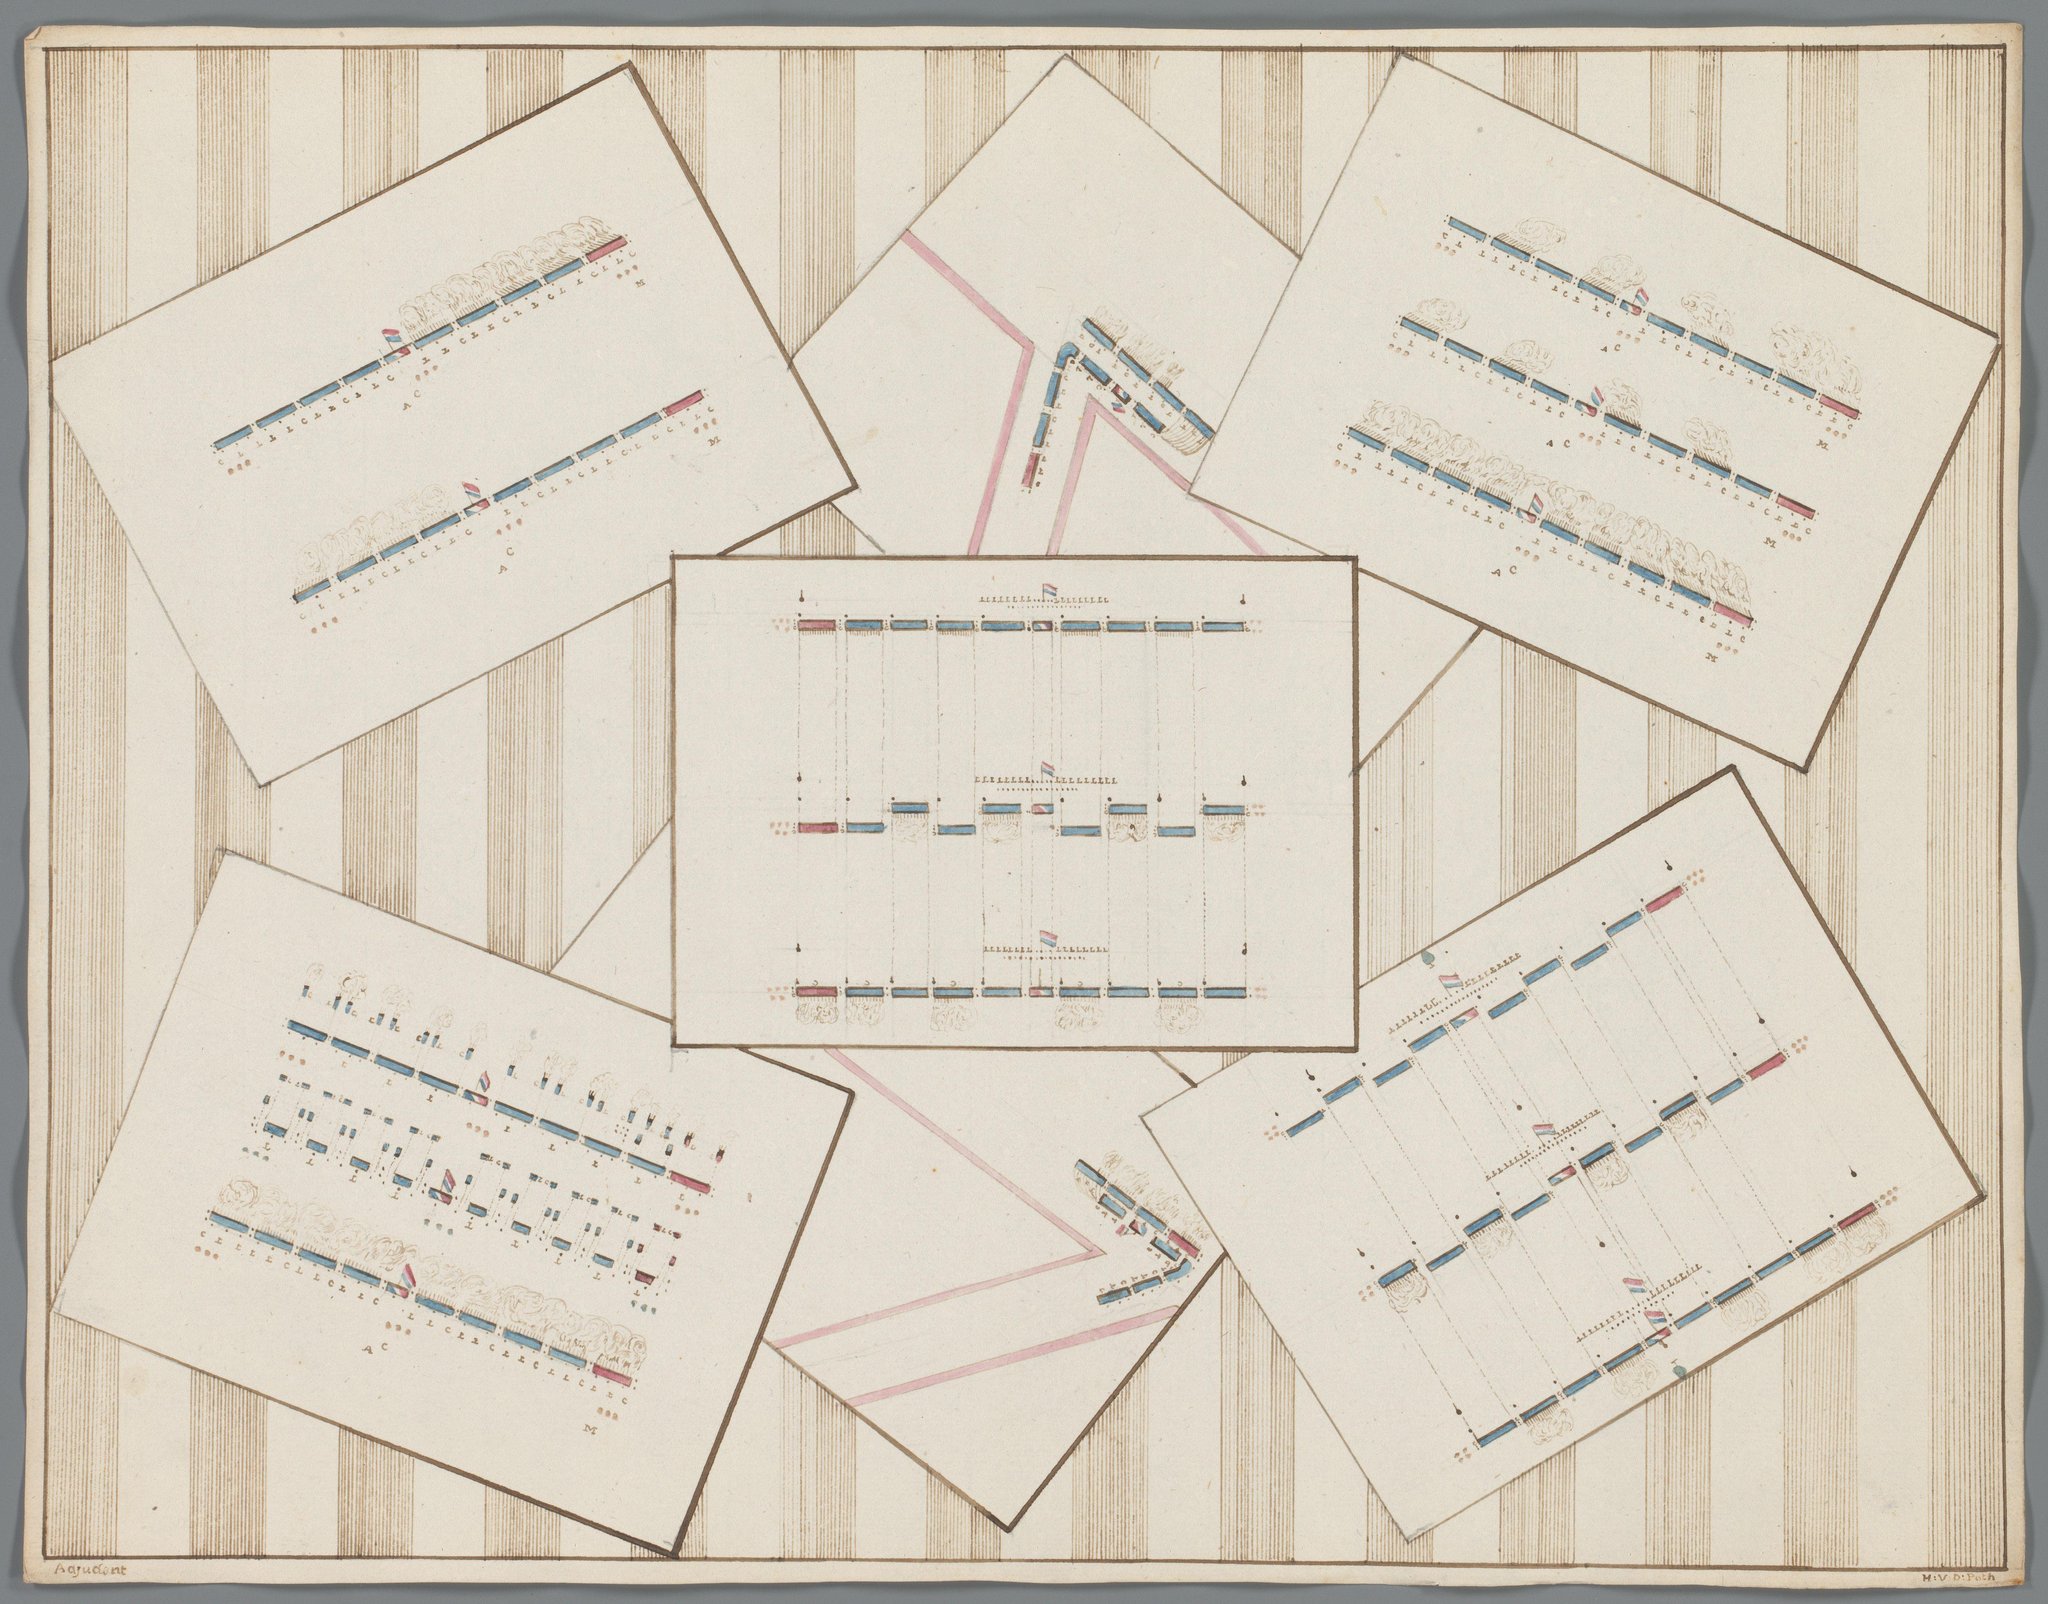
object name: drawing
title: Manoeuvres van de compagnieën, ca. 1799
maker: hendrik van der poth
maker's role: draughtsman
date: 1799-1803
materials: paper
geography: netherlands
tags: manoeuvre ~ military training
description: Blad met zeven kaartjes van verschillende manoeuvres van de zeven compagnieën van het Bataafse bataljon. Ten tijde van de Brits-Russische expeditie in 1799. Onderdeel van een groep van zeventien getekende kaarten.